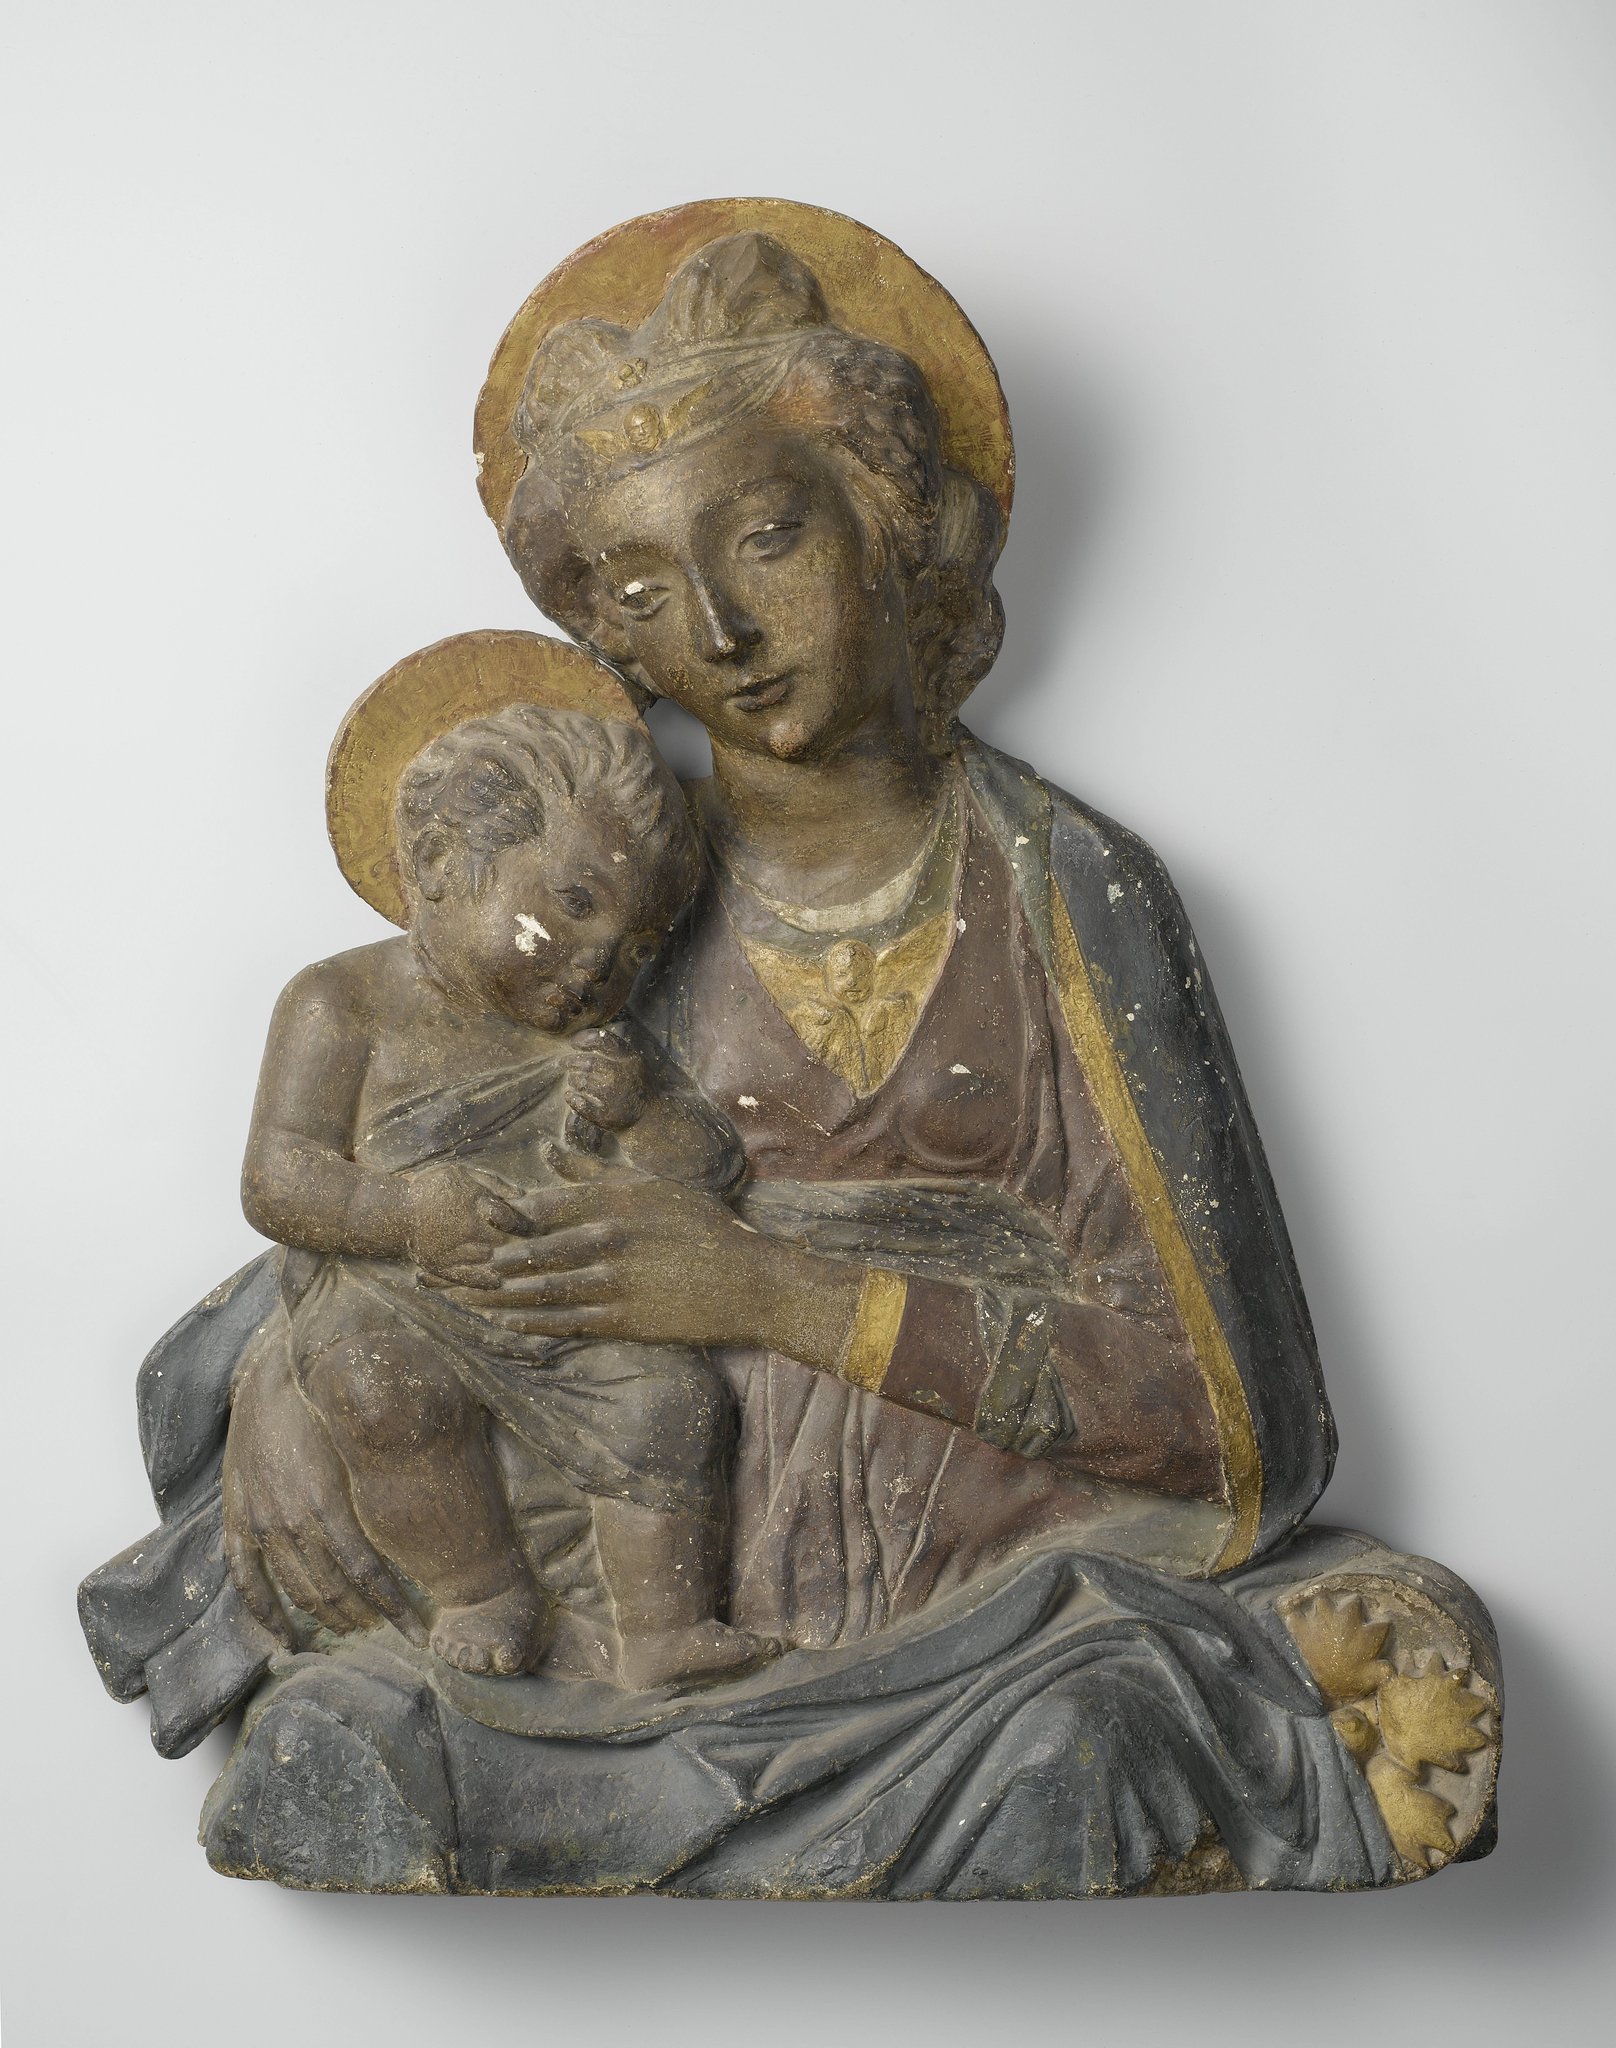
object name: sculpture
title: Maria met kind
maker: antonio rossellino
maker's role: sculptor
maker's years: 1427-1479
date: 1450-1475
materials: plaster